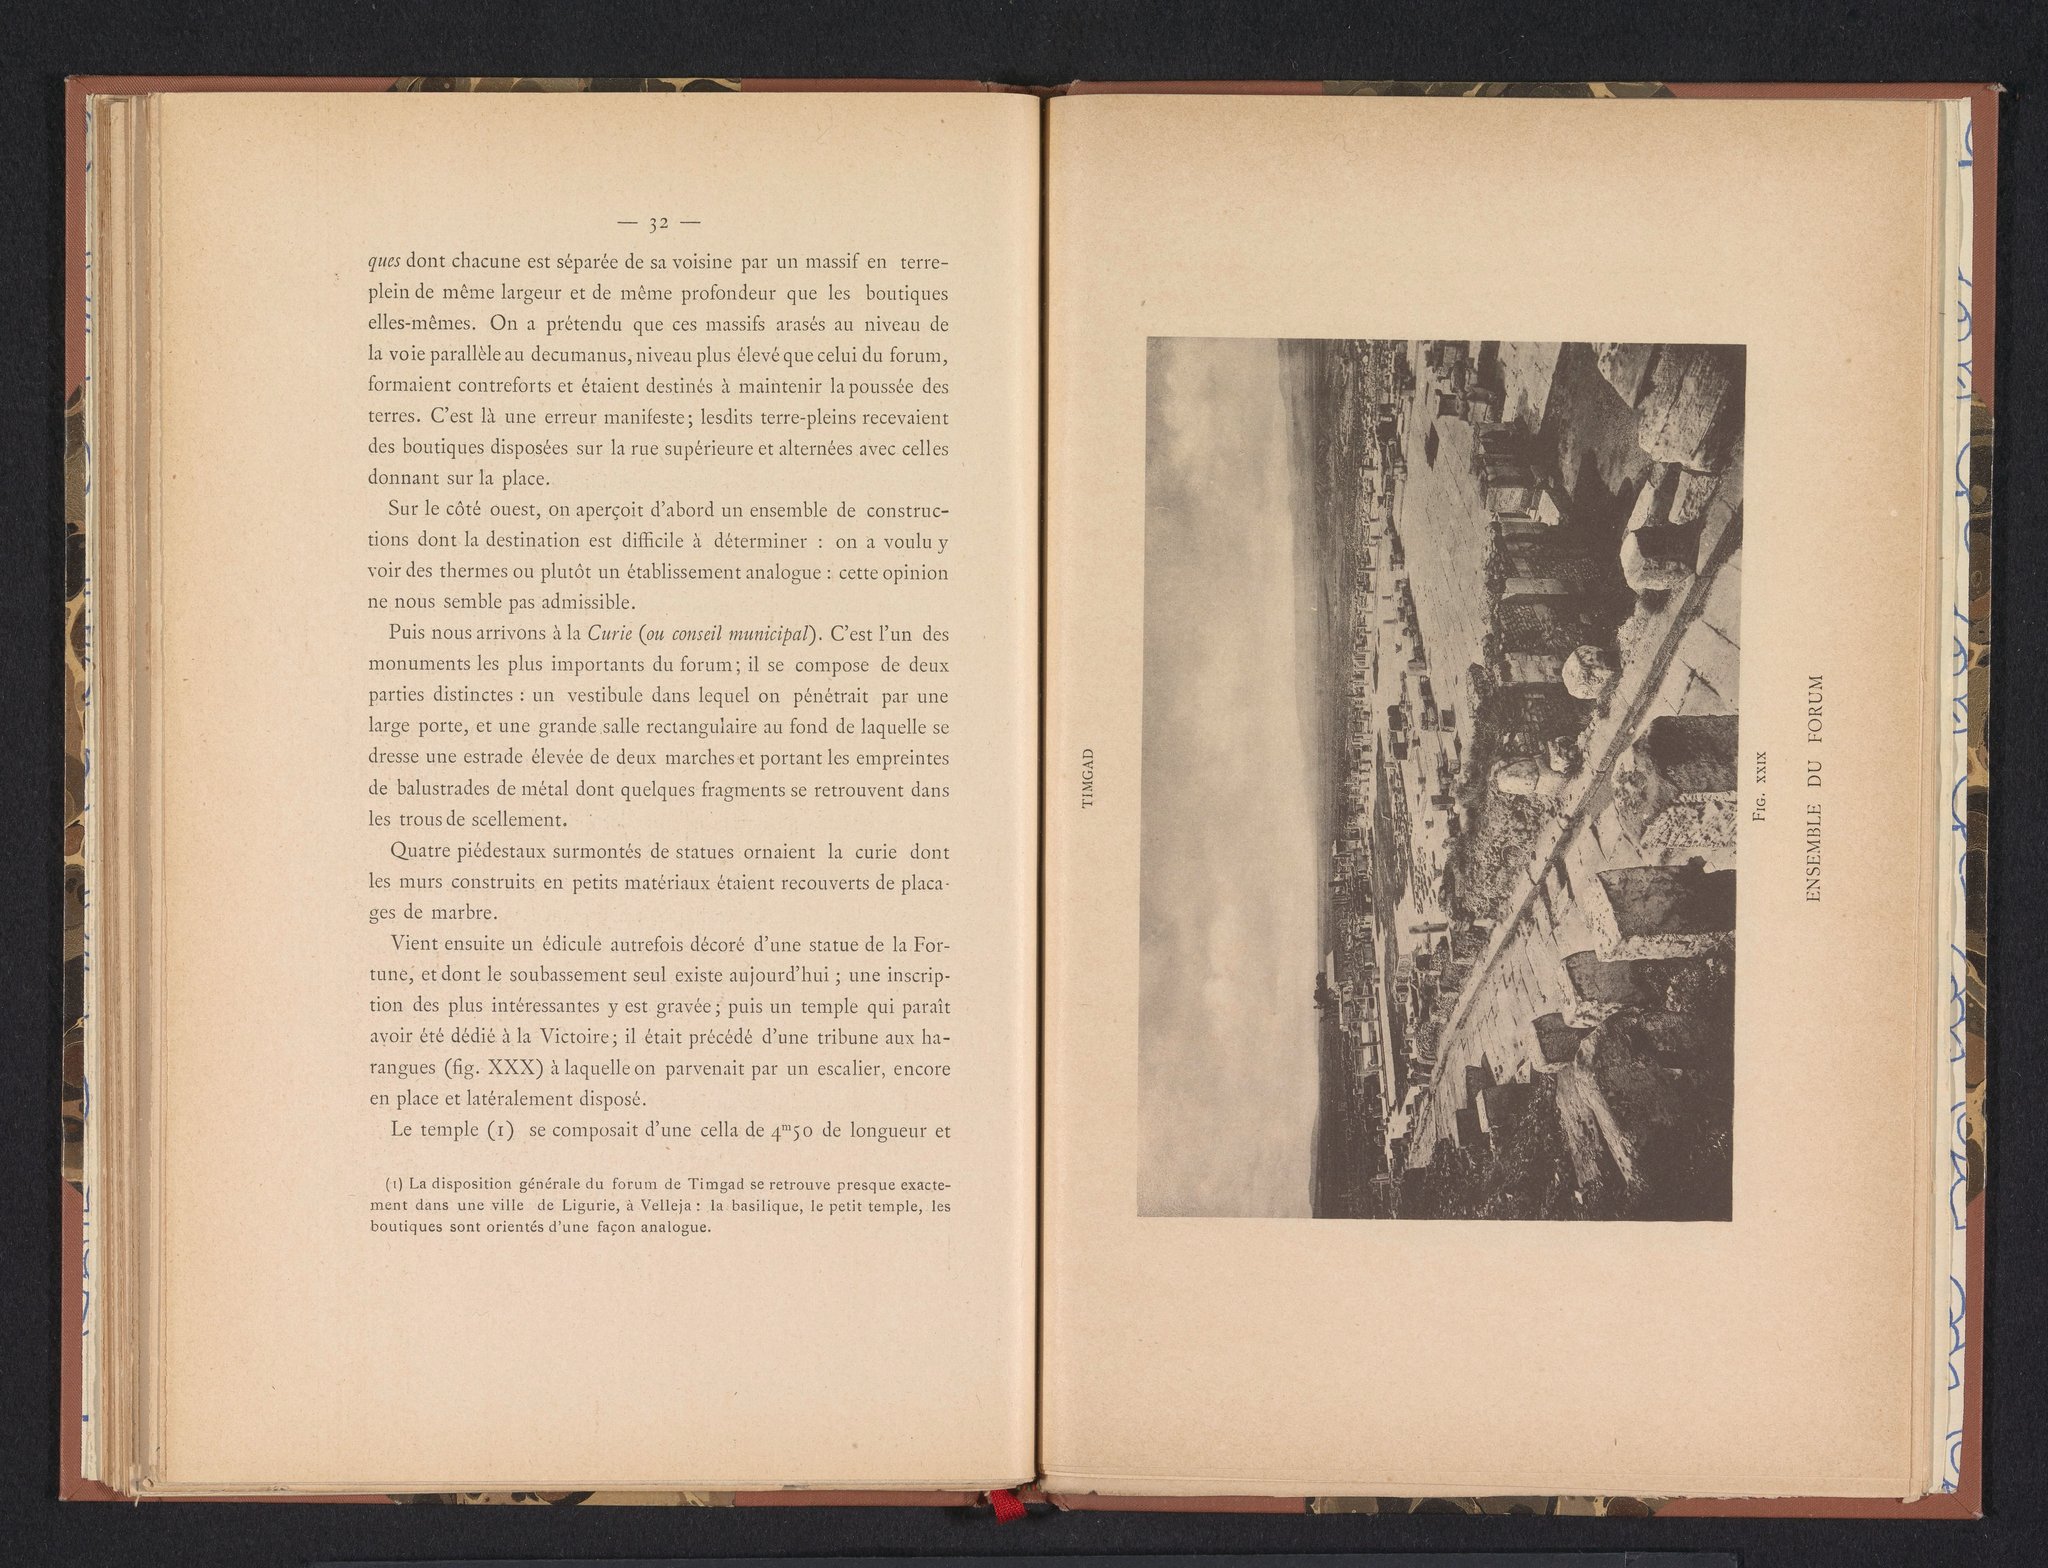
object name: photomechanical print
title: Gezicht op de ruïnes van een Romeins forum in Timgad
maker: Anonymous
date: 1884-1894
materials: paper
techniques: photograph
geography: france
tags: landscape with ruins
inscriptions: number: ‘Fig. XXIX’